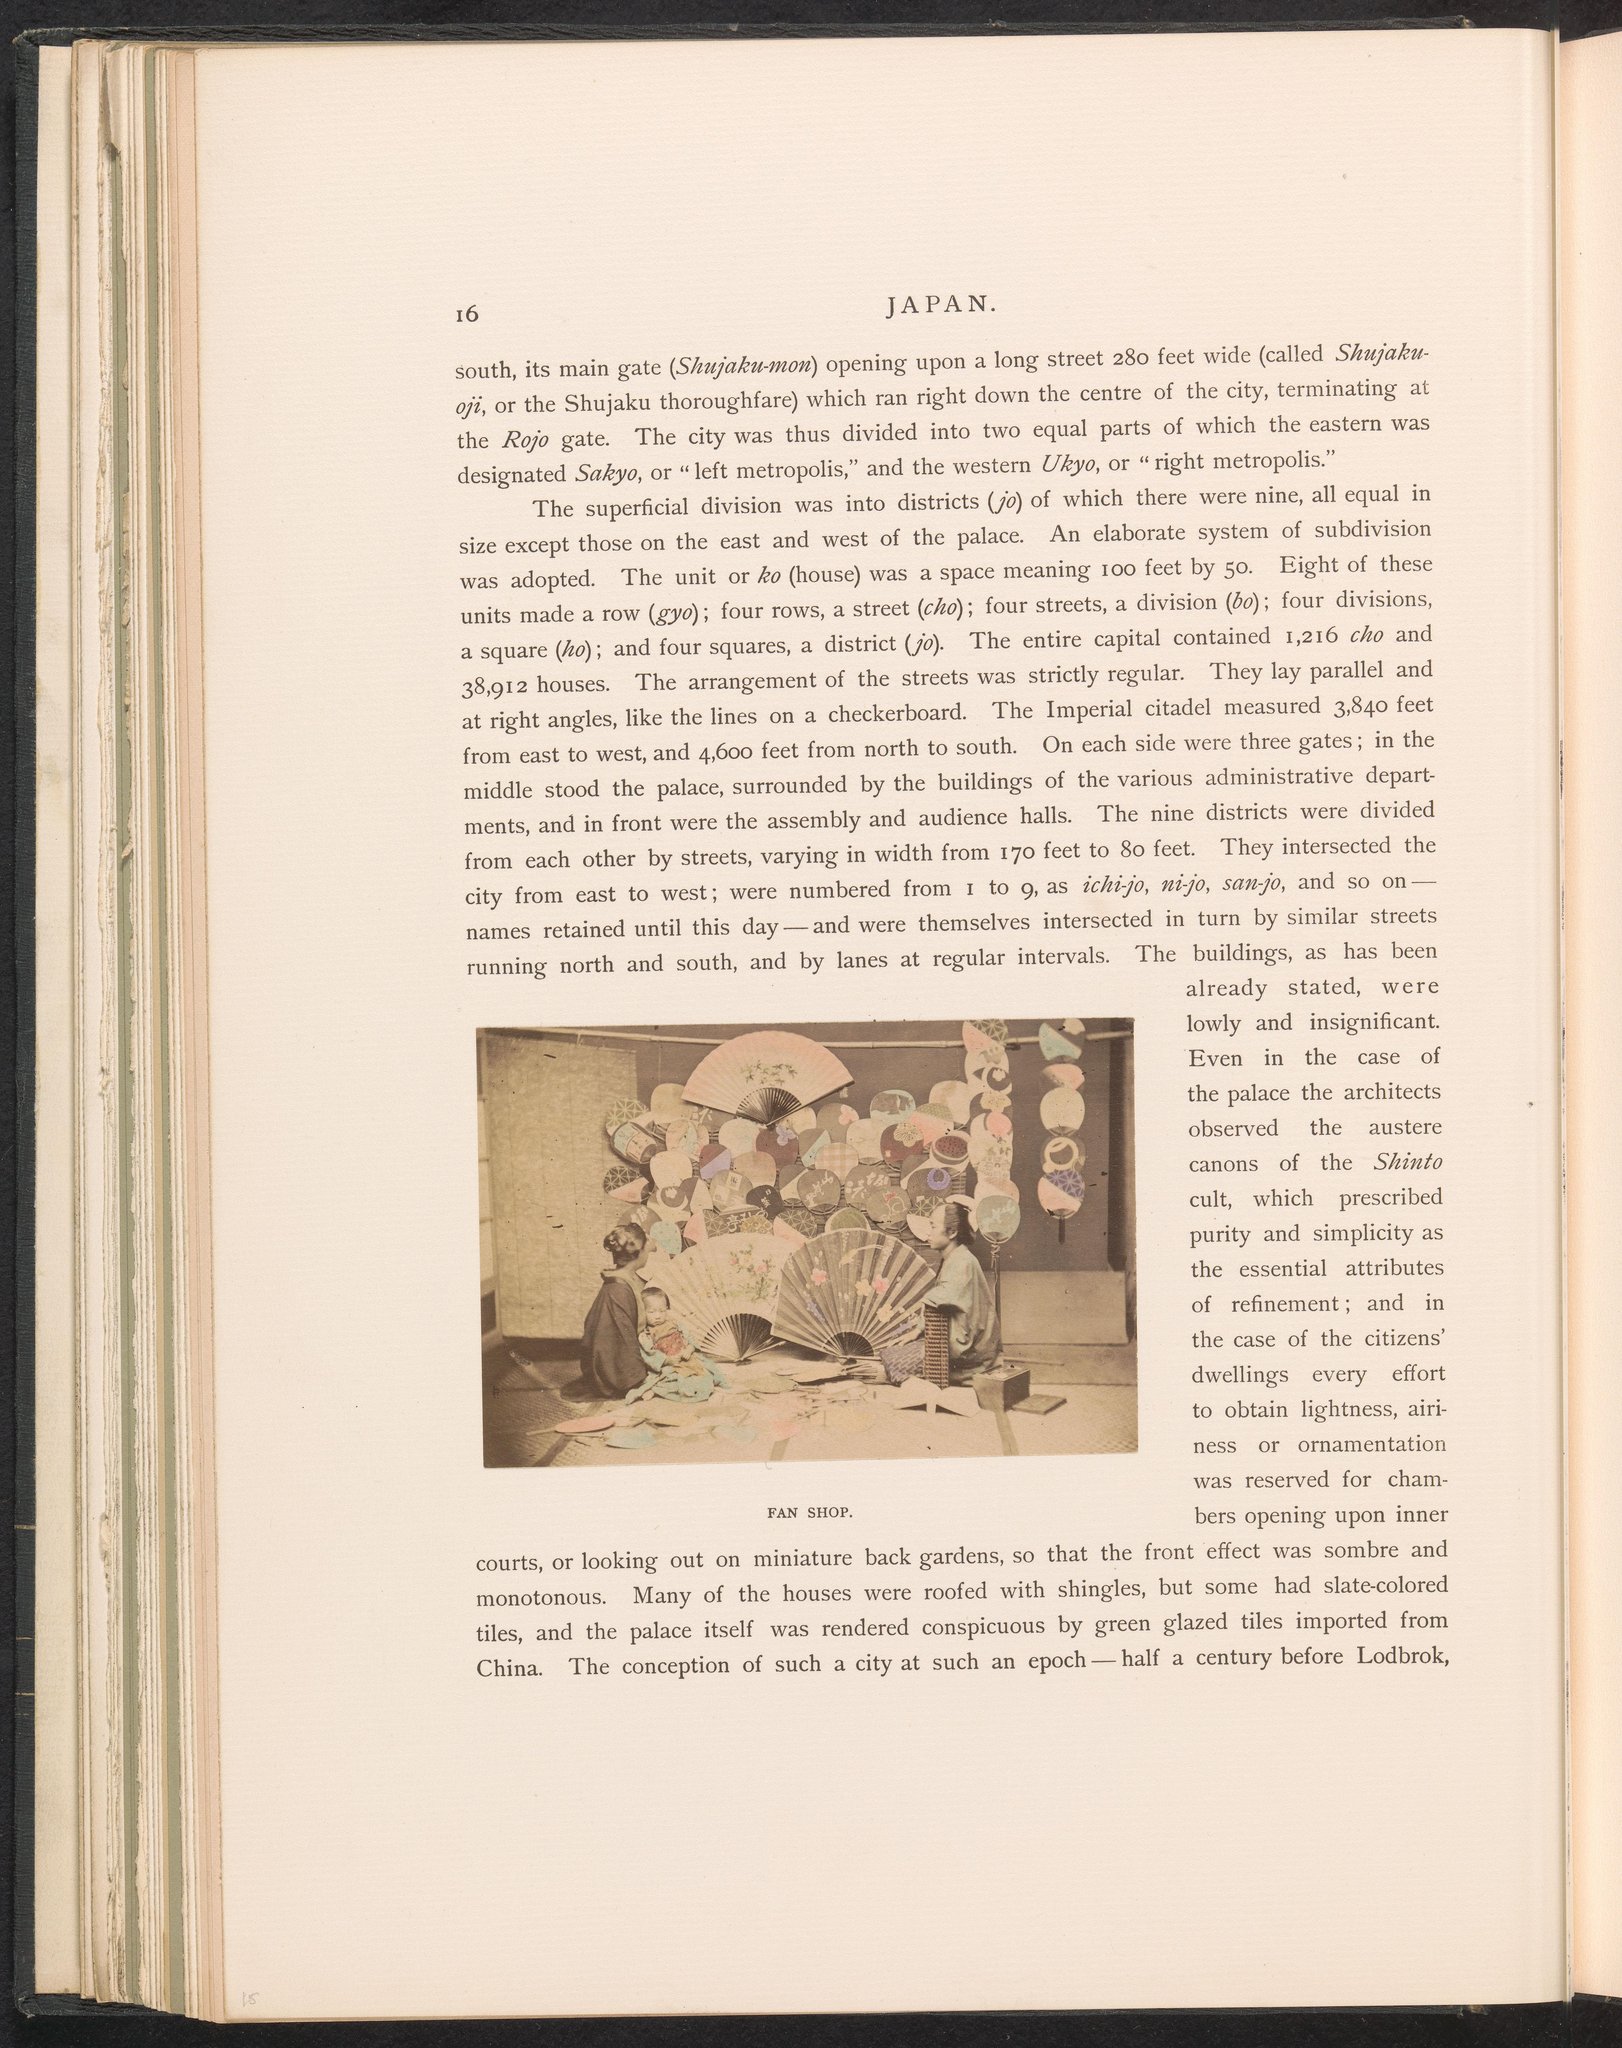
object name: page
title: Fan shop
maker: Anonymous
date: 1887-1897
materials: photographic support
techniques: albumen print, hand coloring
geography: japan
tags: shop, store, fan